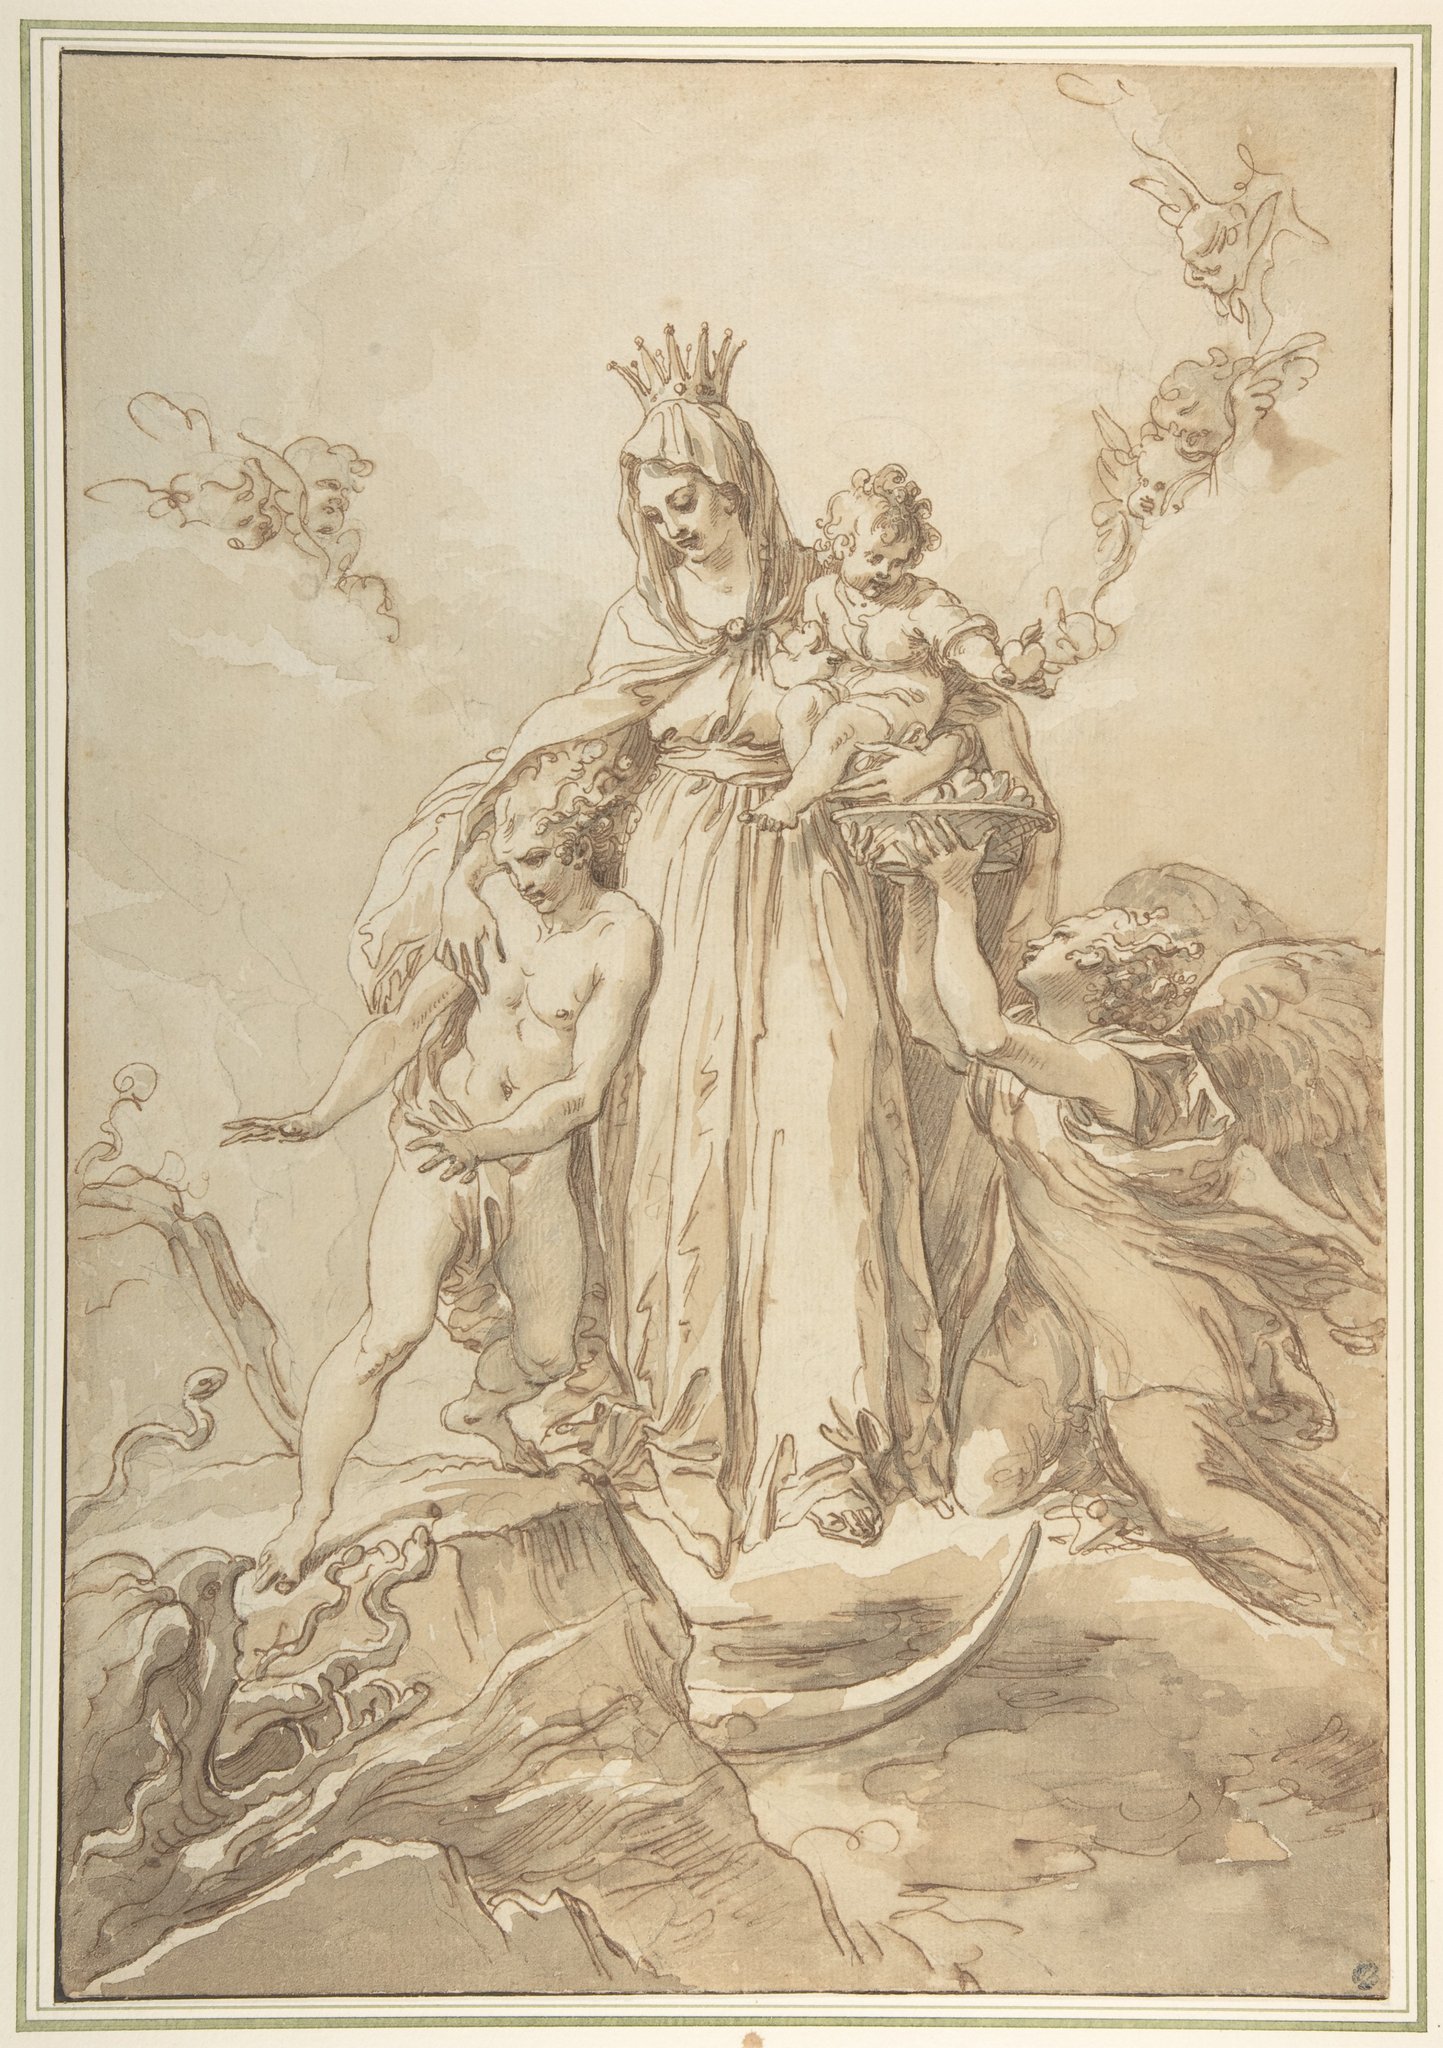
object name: drawing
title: The Virgin Immaculate with the Christ Child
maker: giuseppe cades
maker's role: artist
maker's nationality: italian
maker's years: 1750-1799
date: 1770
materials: chalk, ink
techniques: brush, pen, wash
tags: angels,madonna and child